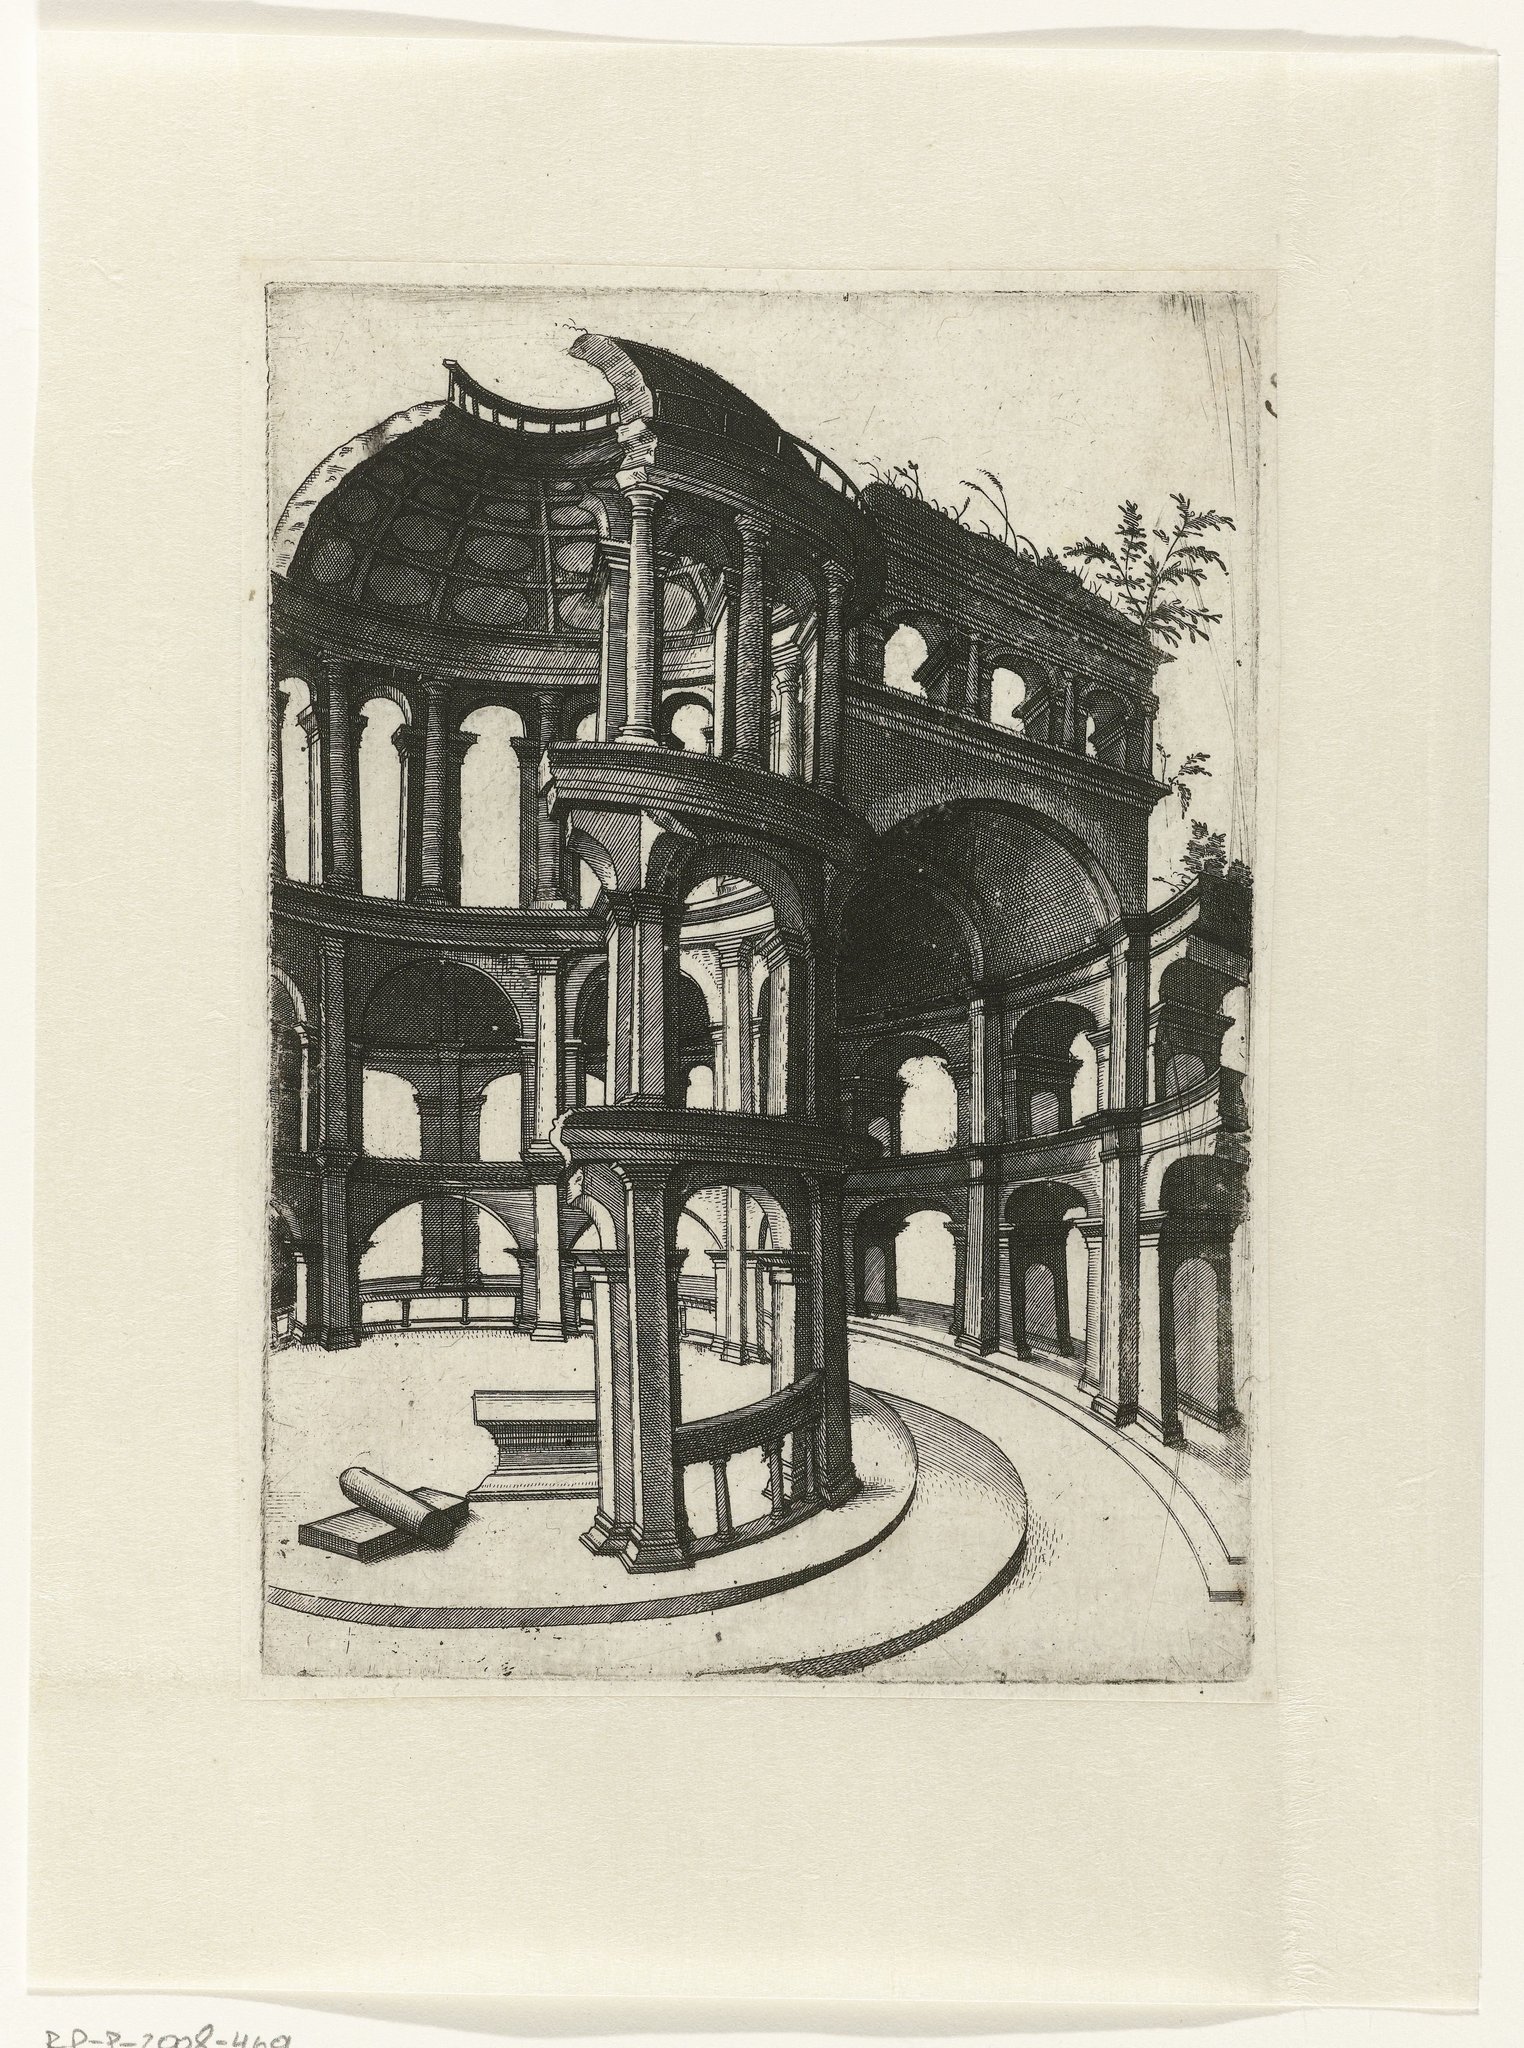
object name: print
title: Ruïne met rondbogen en koepel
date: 1560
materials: paper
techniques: engraving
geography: antwerp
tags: ruin of a building ~ architecture, landscape with ruins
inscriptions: collector's mark: Lugt 2760, collector's mark: Lugt 2228